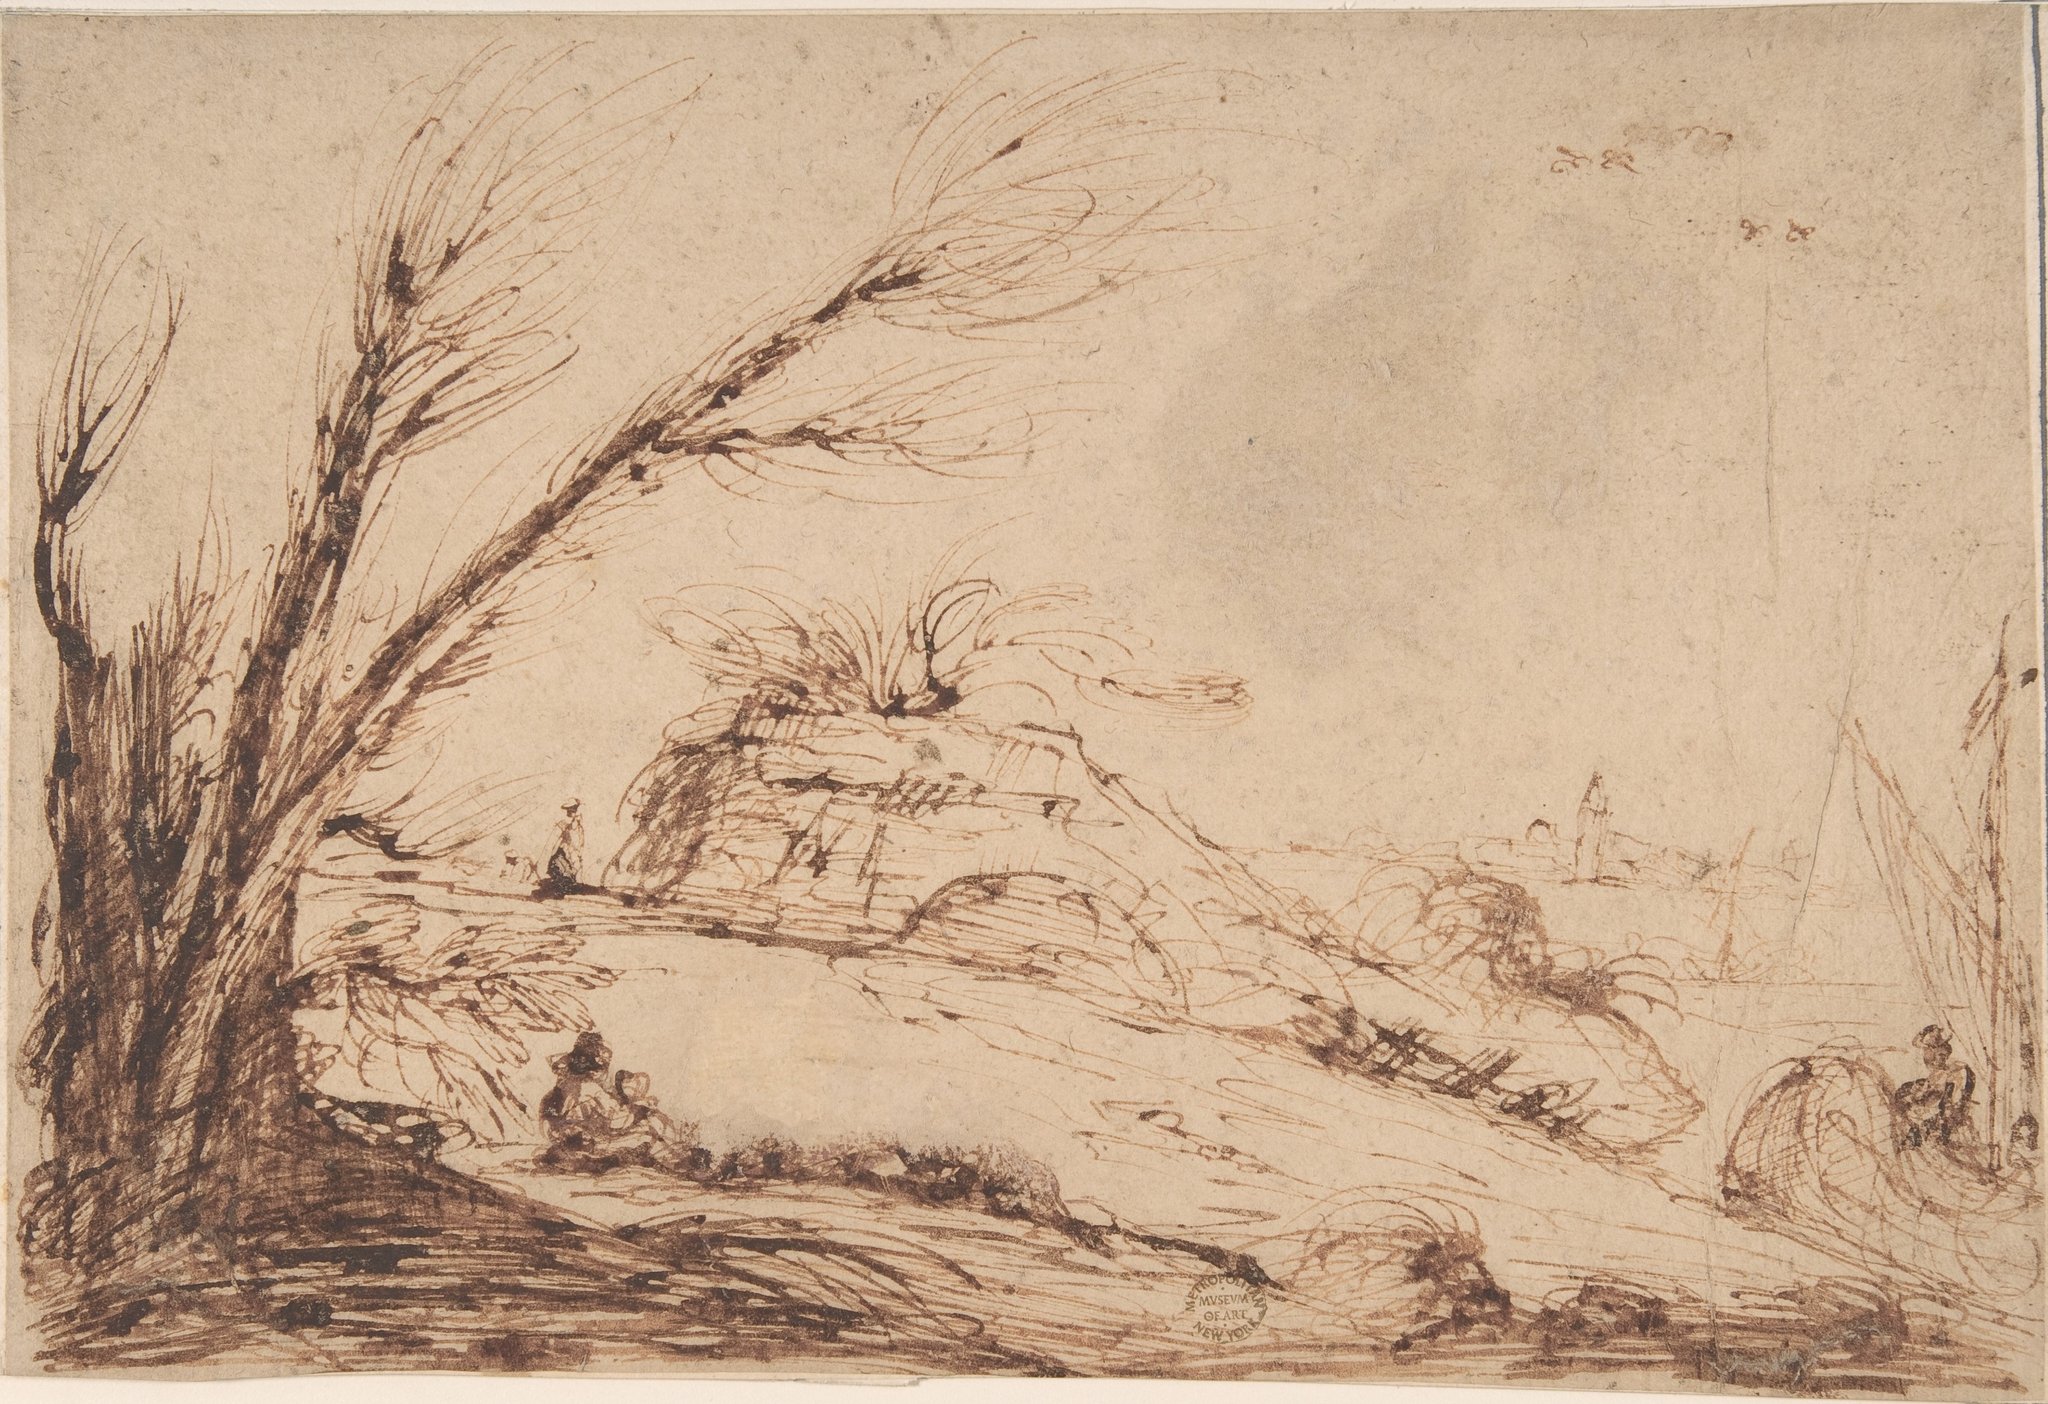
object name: drawing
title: Landscape with Figures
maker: anonymous, italian, roman-bolognese, 17th century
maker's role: artist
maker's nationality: italian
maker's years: 1600-1700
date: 1601-1700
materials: ink, paper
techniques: pen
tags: human figures,landscapes,plants